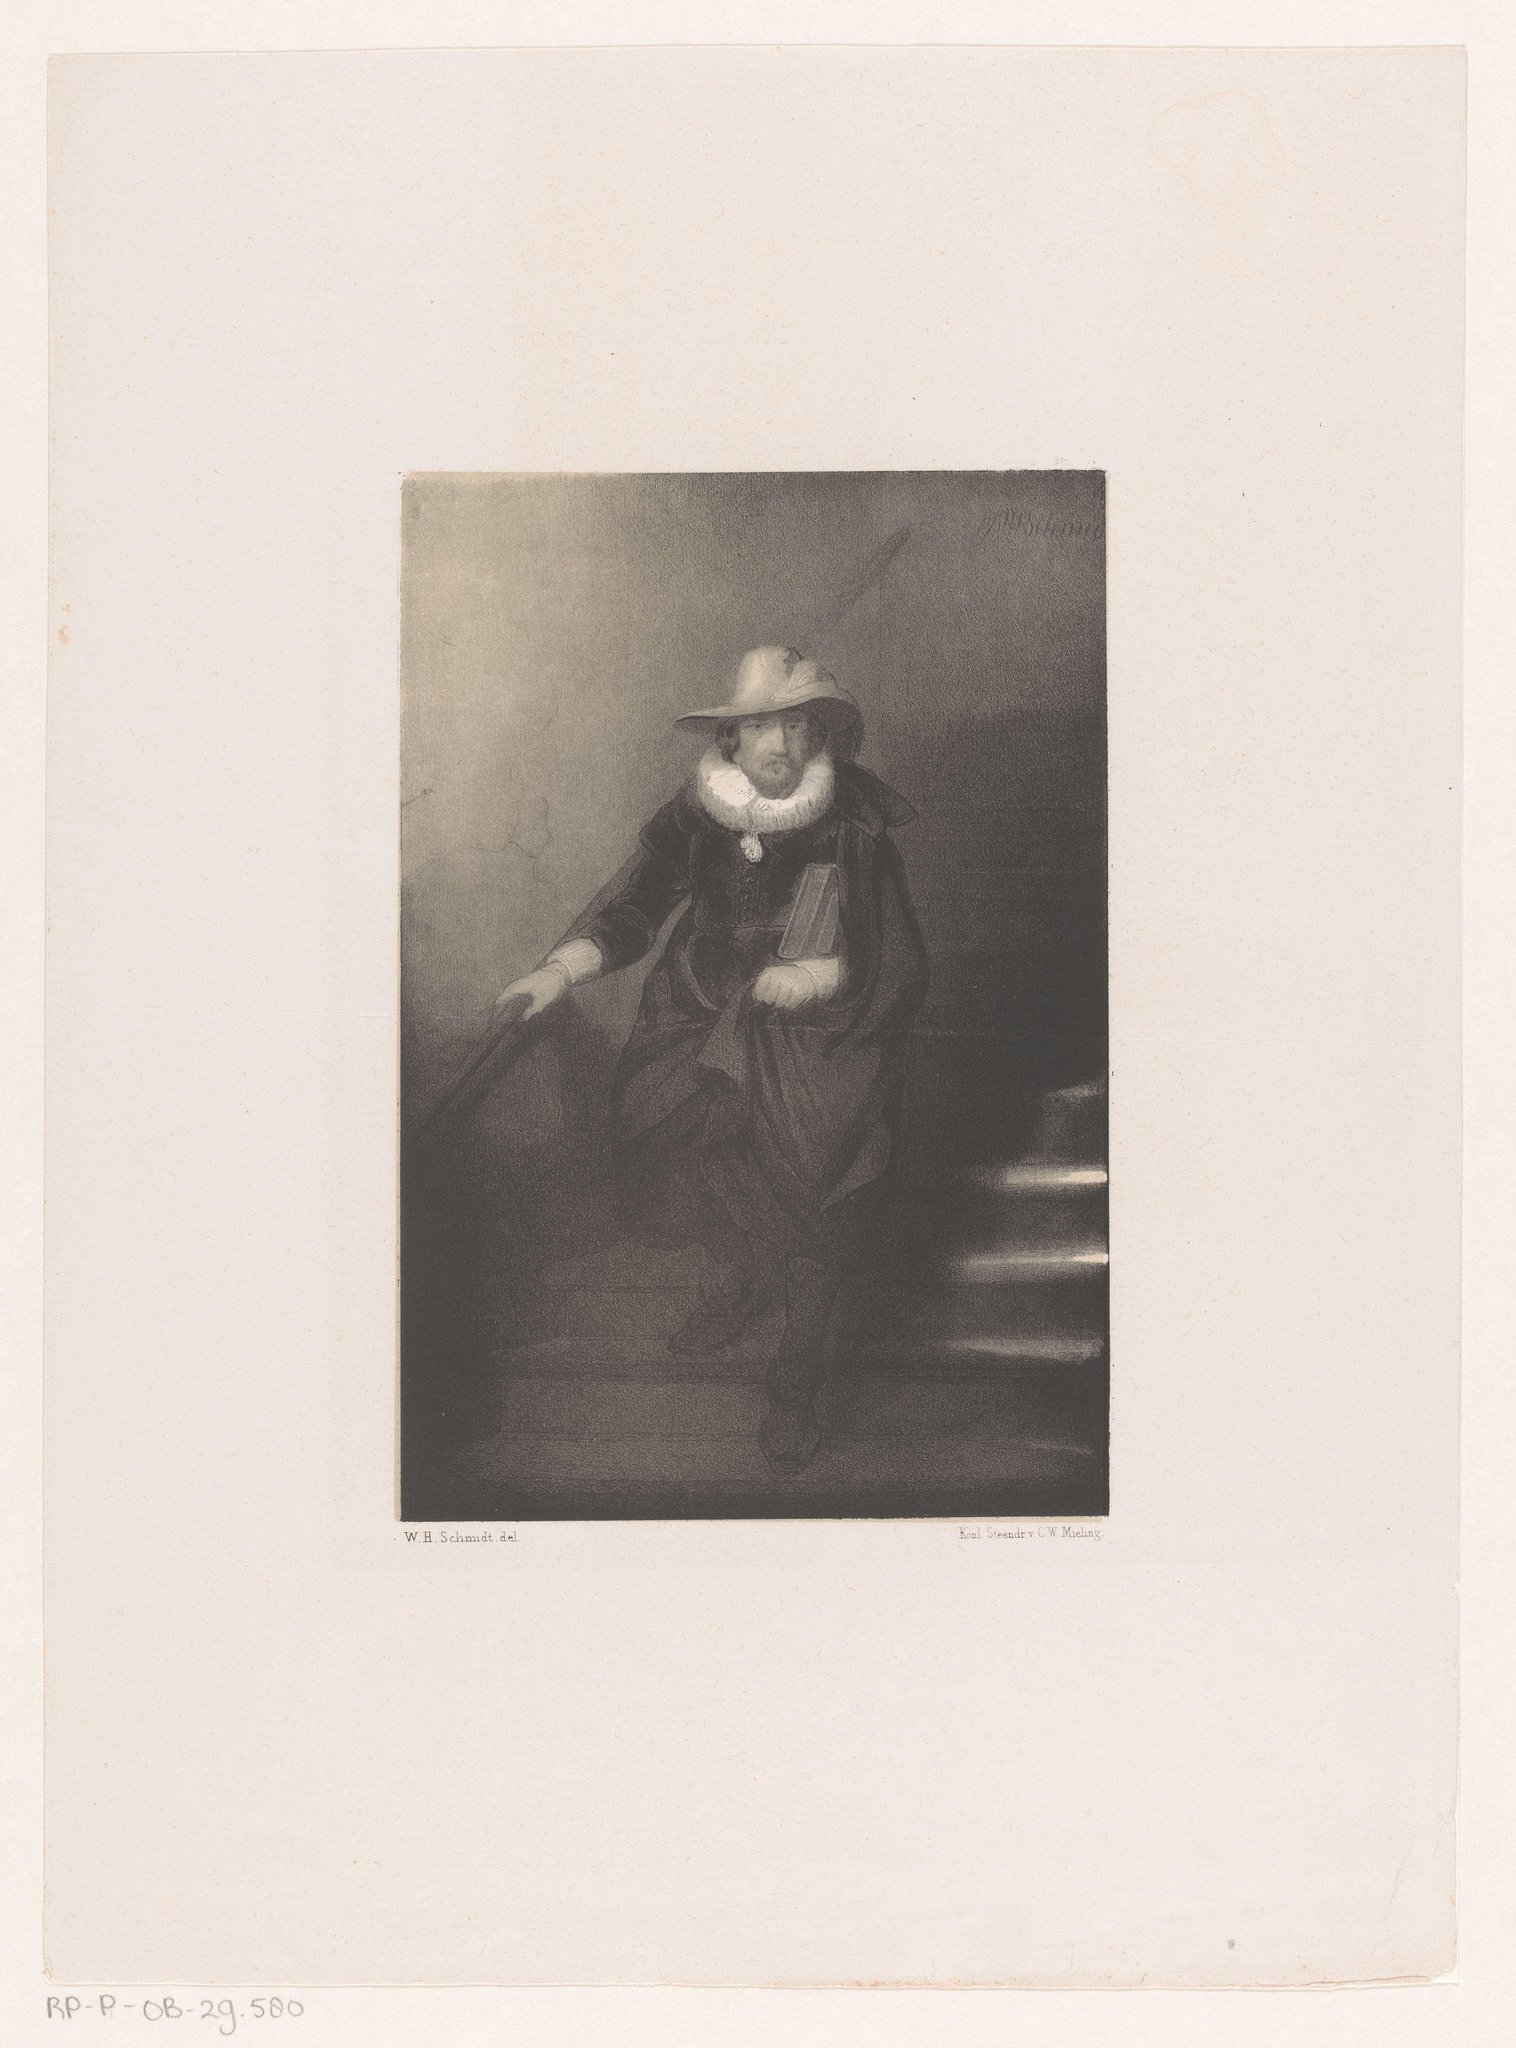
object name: print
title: Man daalt trap af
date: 1847-1849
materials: paper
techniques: tone lithography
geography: the hague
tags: walking, staircase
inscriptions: collector's mark: Lugt 2228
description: Een man in zeventiende-eeuwse kleding met boeken onder zijn arm daalt een trap af.